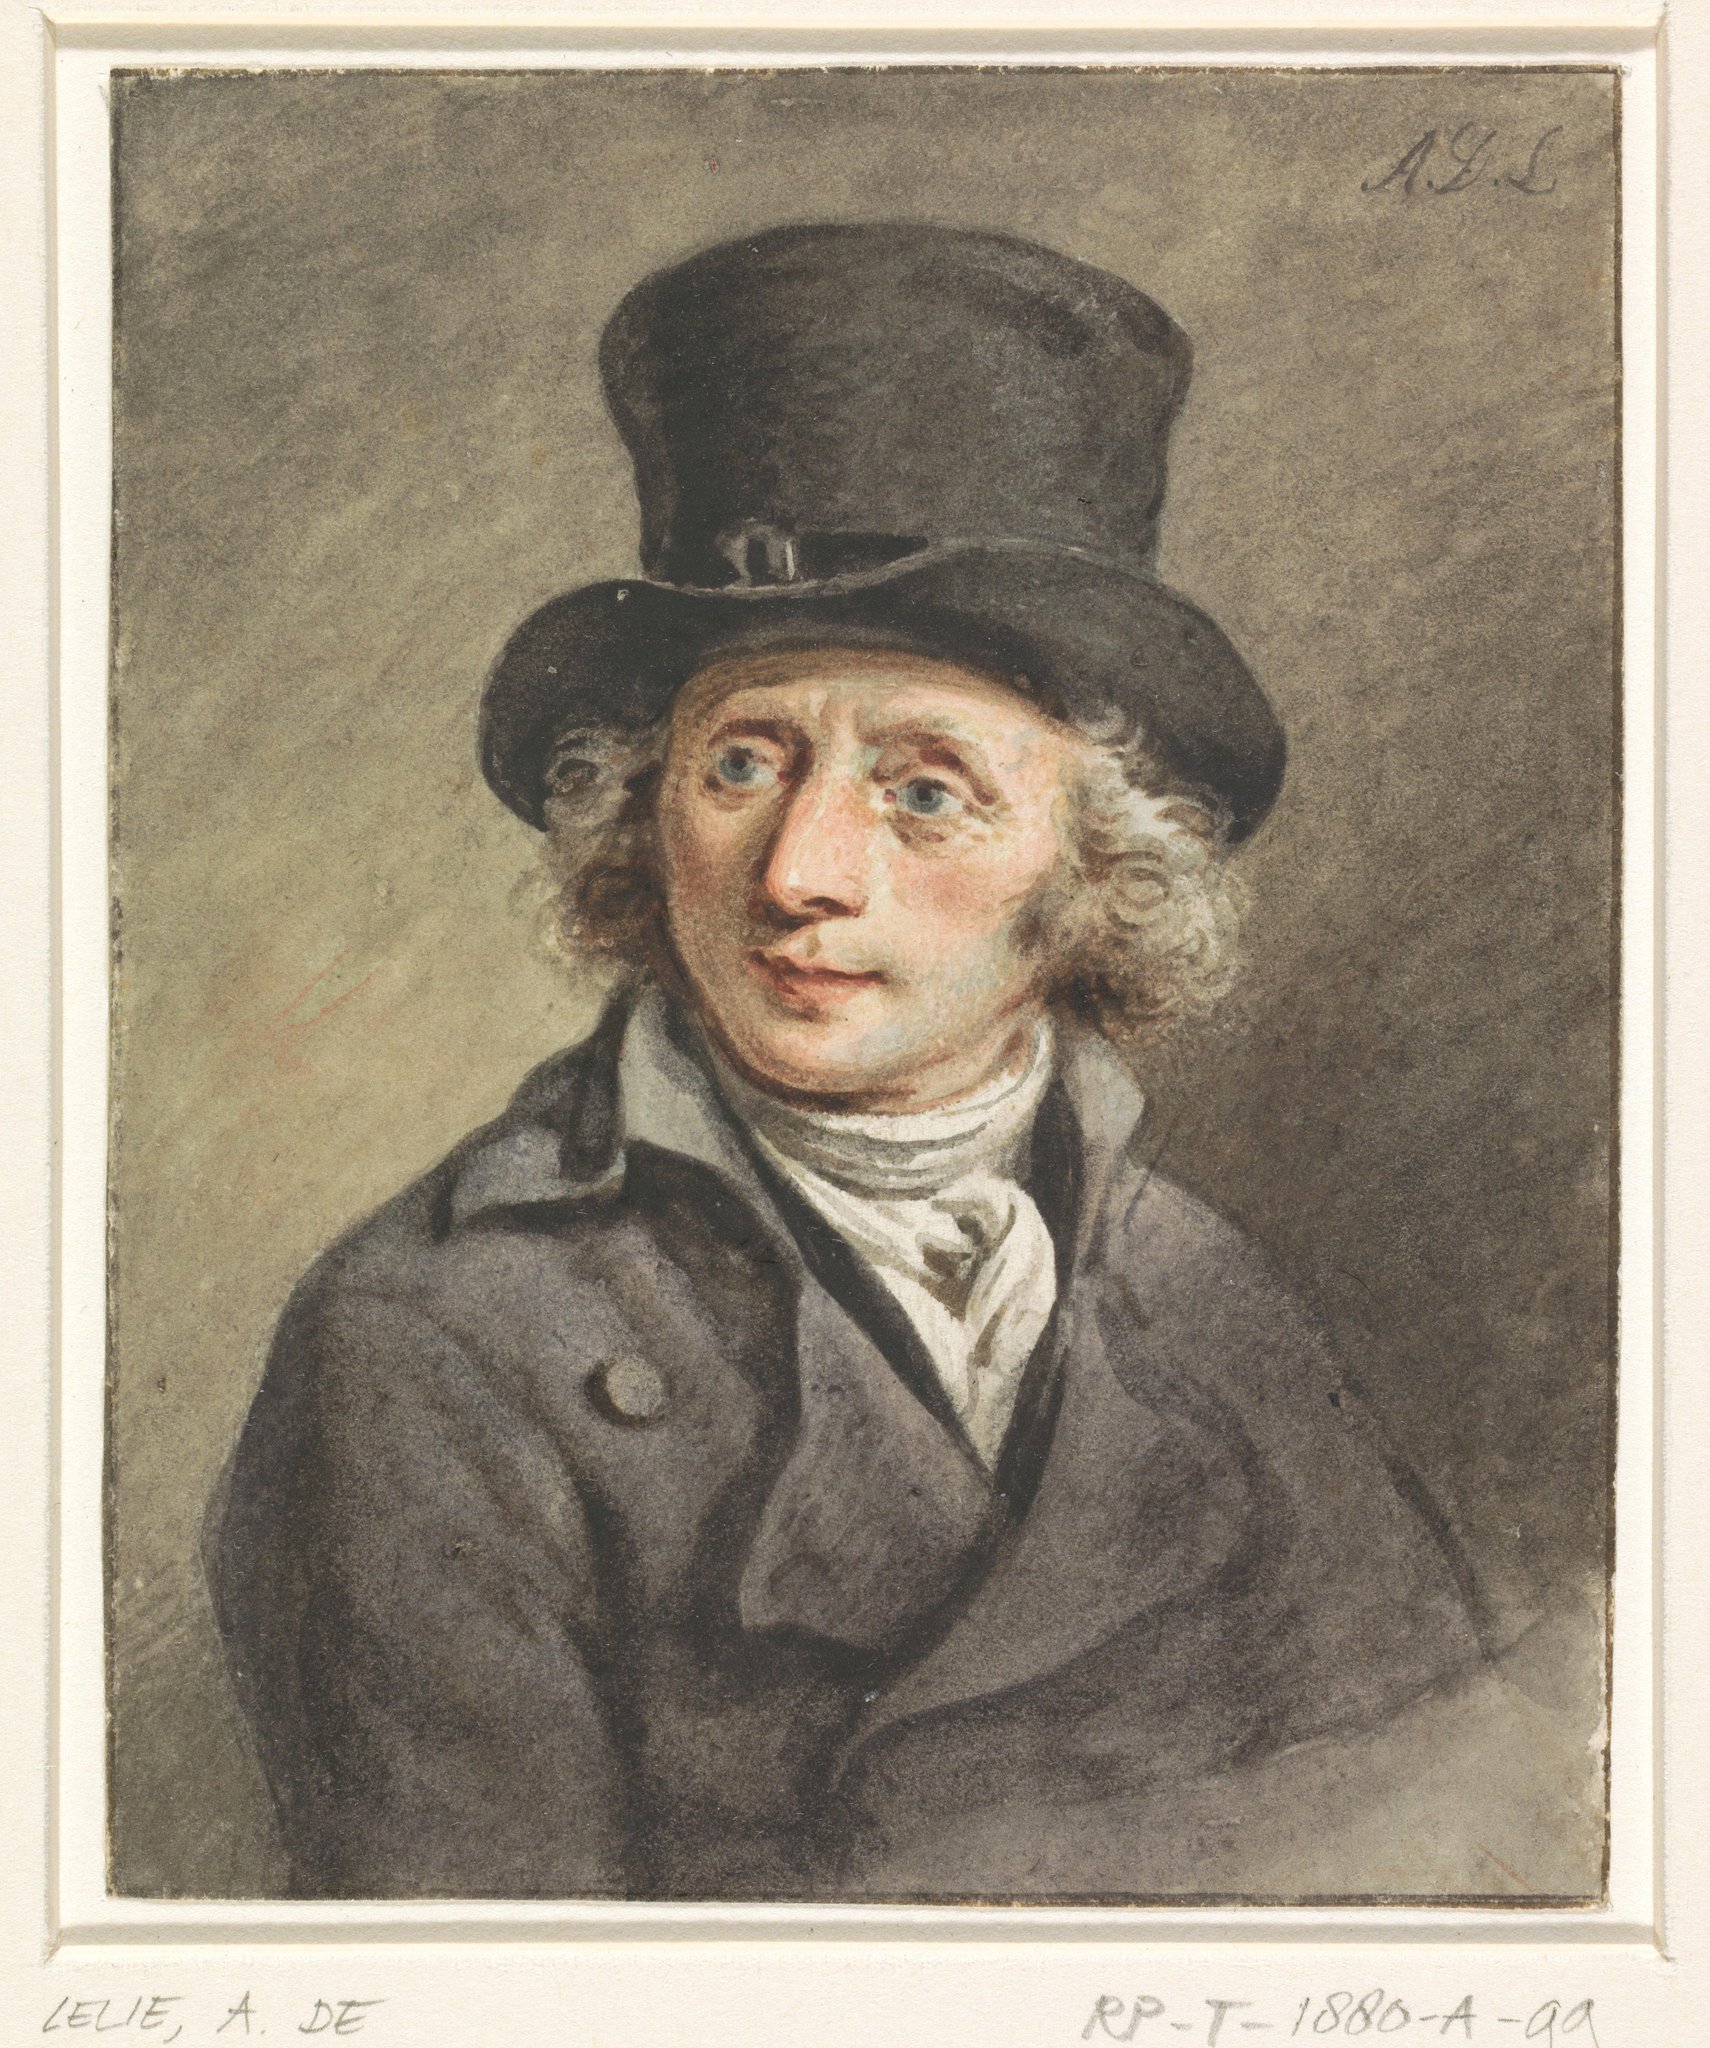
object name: watercolor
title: Zelfportret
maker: adriaan de lelie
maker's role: draughtsman, painter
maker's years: 1755-1820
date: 1765-1820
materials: paper, watercolor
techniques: brush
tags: amsterdam, painter, draughtsman, adriaan de lelie, historical persons, portrait, self-portrait of painter, portrait, self-portrait of artist